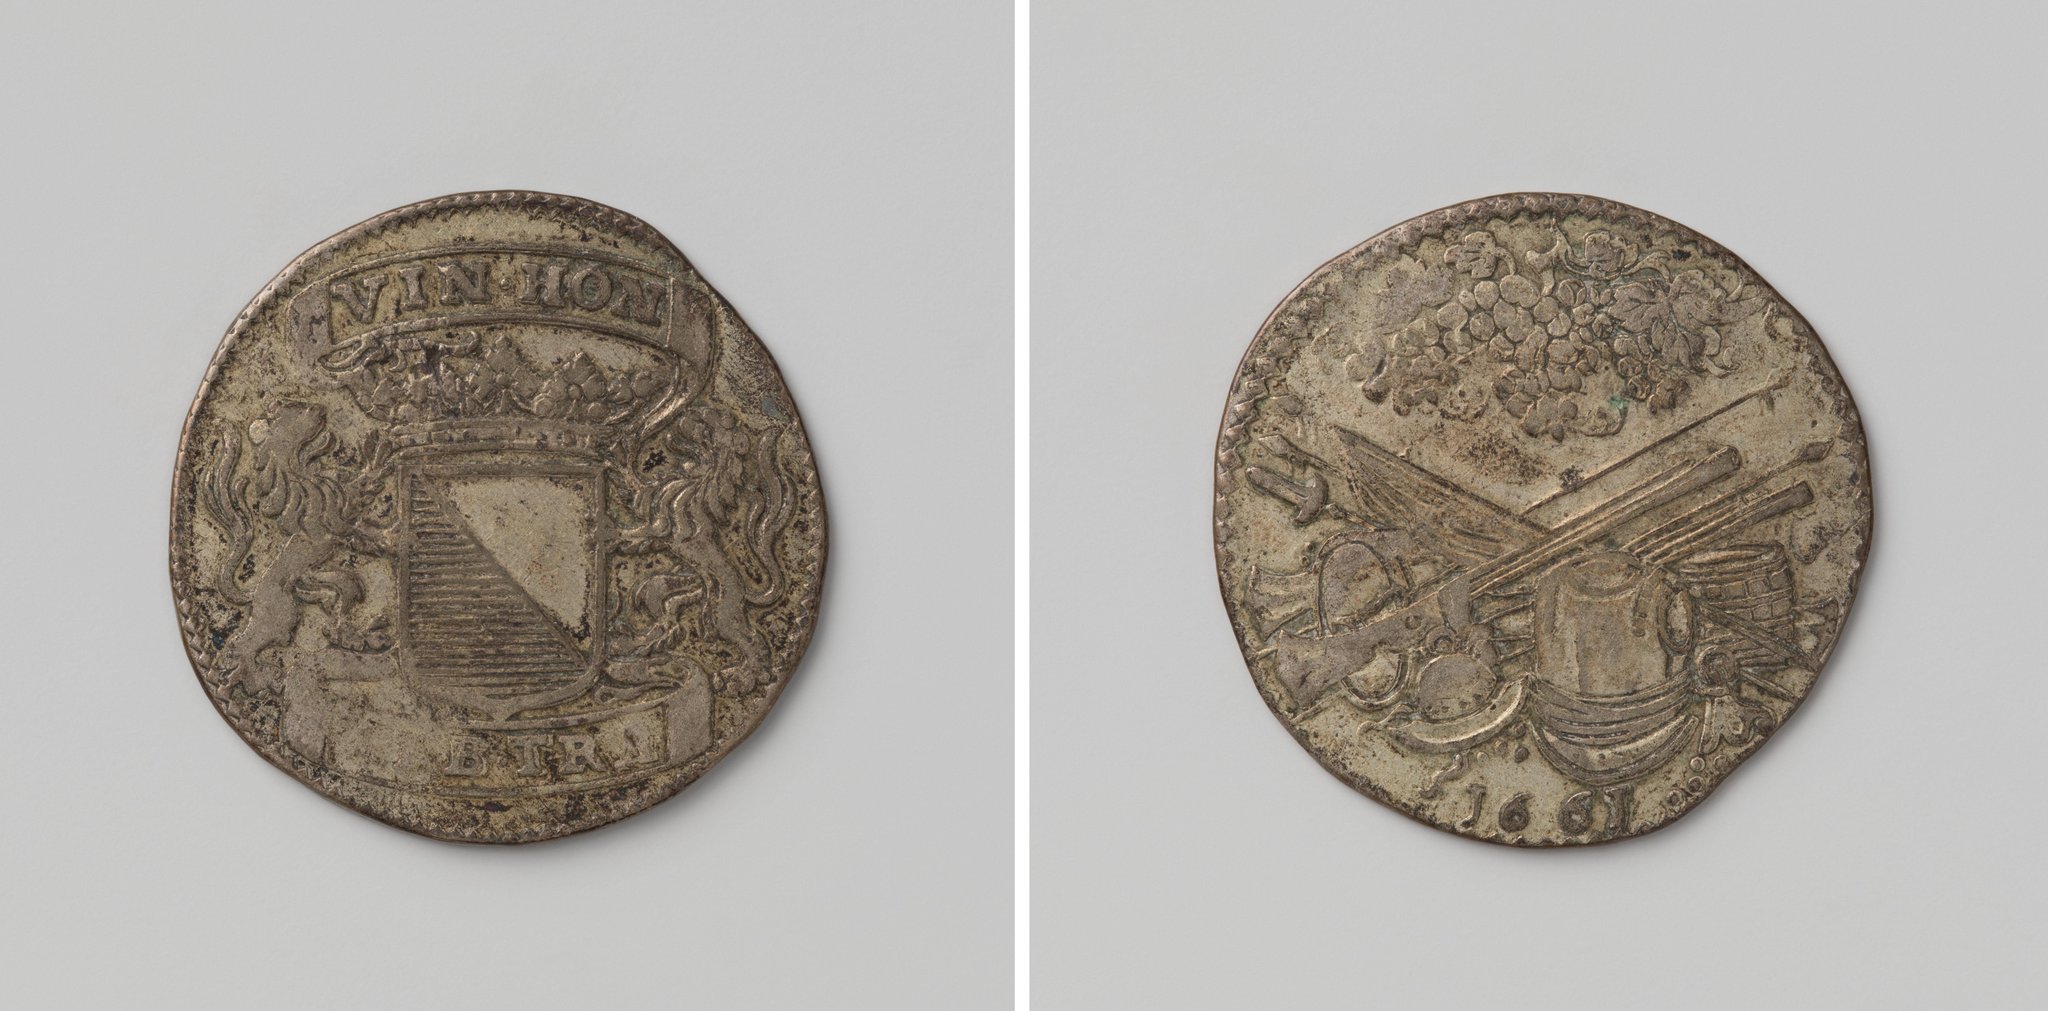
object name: marksman medal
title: Schutterij van Utrecht, penning die schutters recht gaf op een kan wijn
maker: roelof van cuylenburch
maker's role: goldsmith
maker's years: 1607-1673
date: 1661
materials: silver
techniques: striking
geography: utrecht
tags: utrecht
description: Zilveren wijn- en schutterspenning van Utrecht. Voorzijde: gekroond wapenschild, geflankeerd door twee leeuwen onder en boven wimpel met opschrift. Keerzijde: druiventros boven wapentrophee bestaande uit harnas, vaandels, trom en wapentuig; daaronder: jaartal